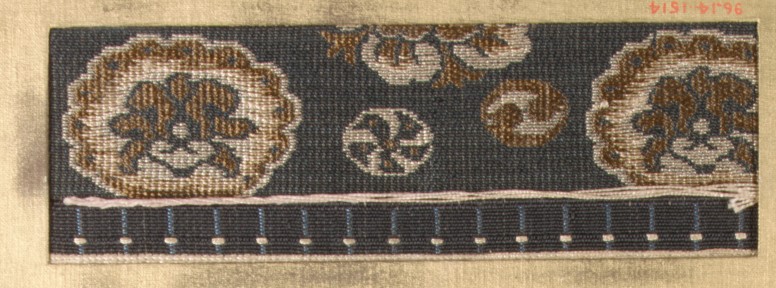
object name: piece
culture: japanese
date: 1701-1900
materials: silk